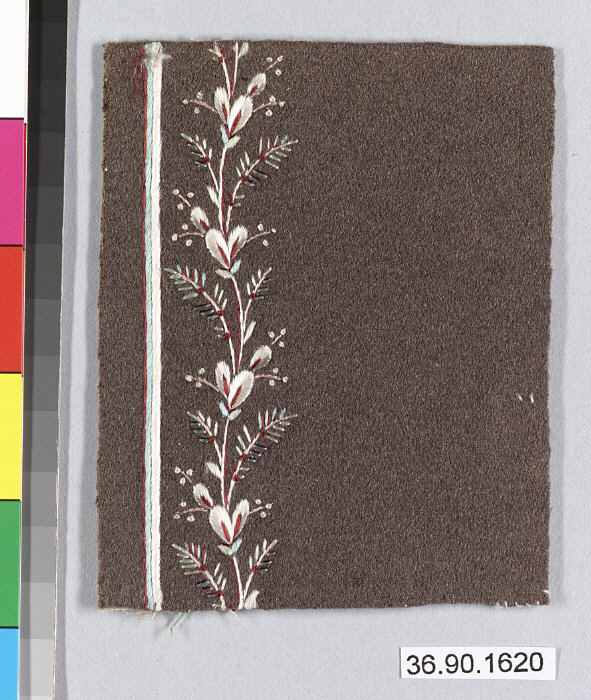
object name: sample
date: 1801-1833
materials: felt, silk